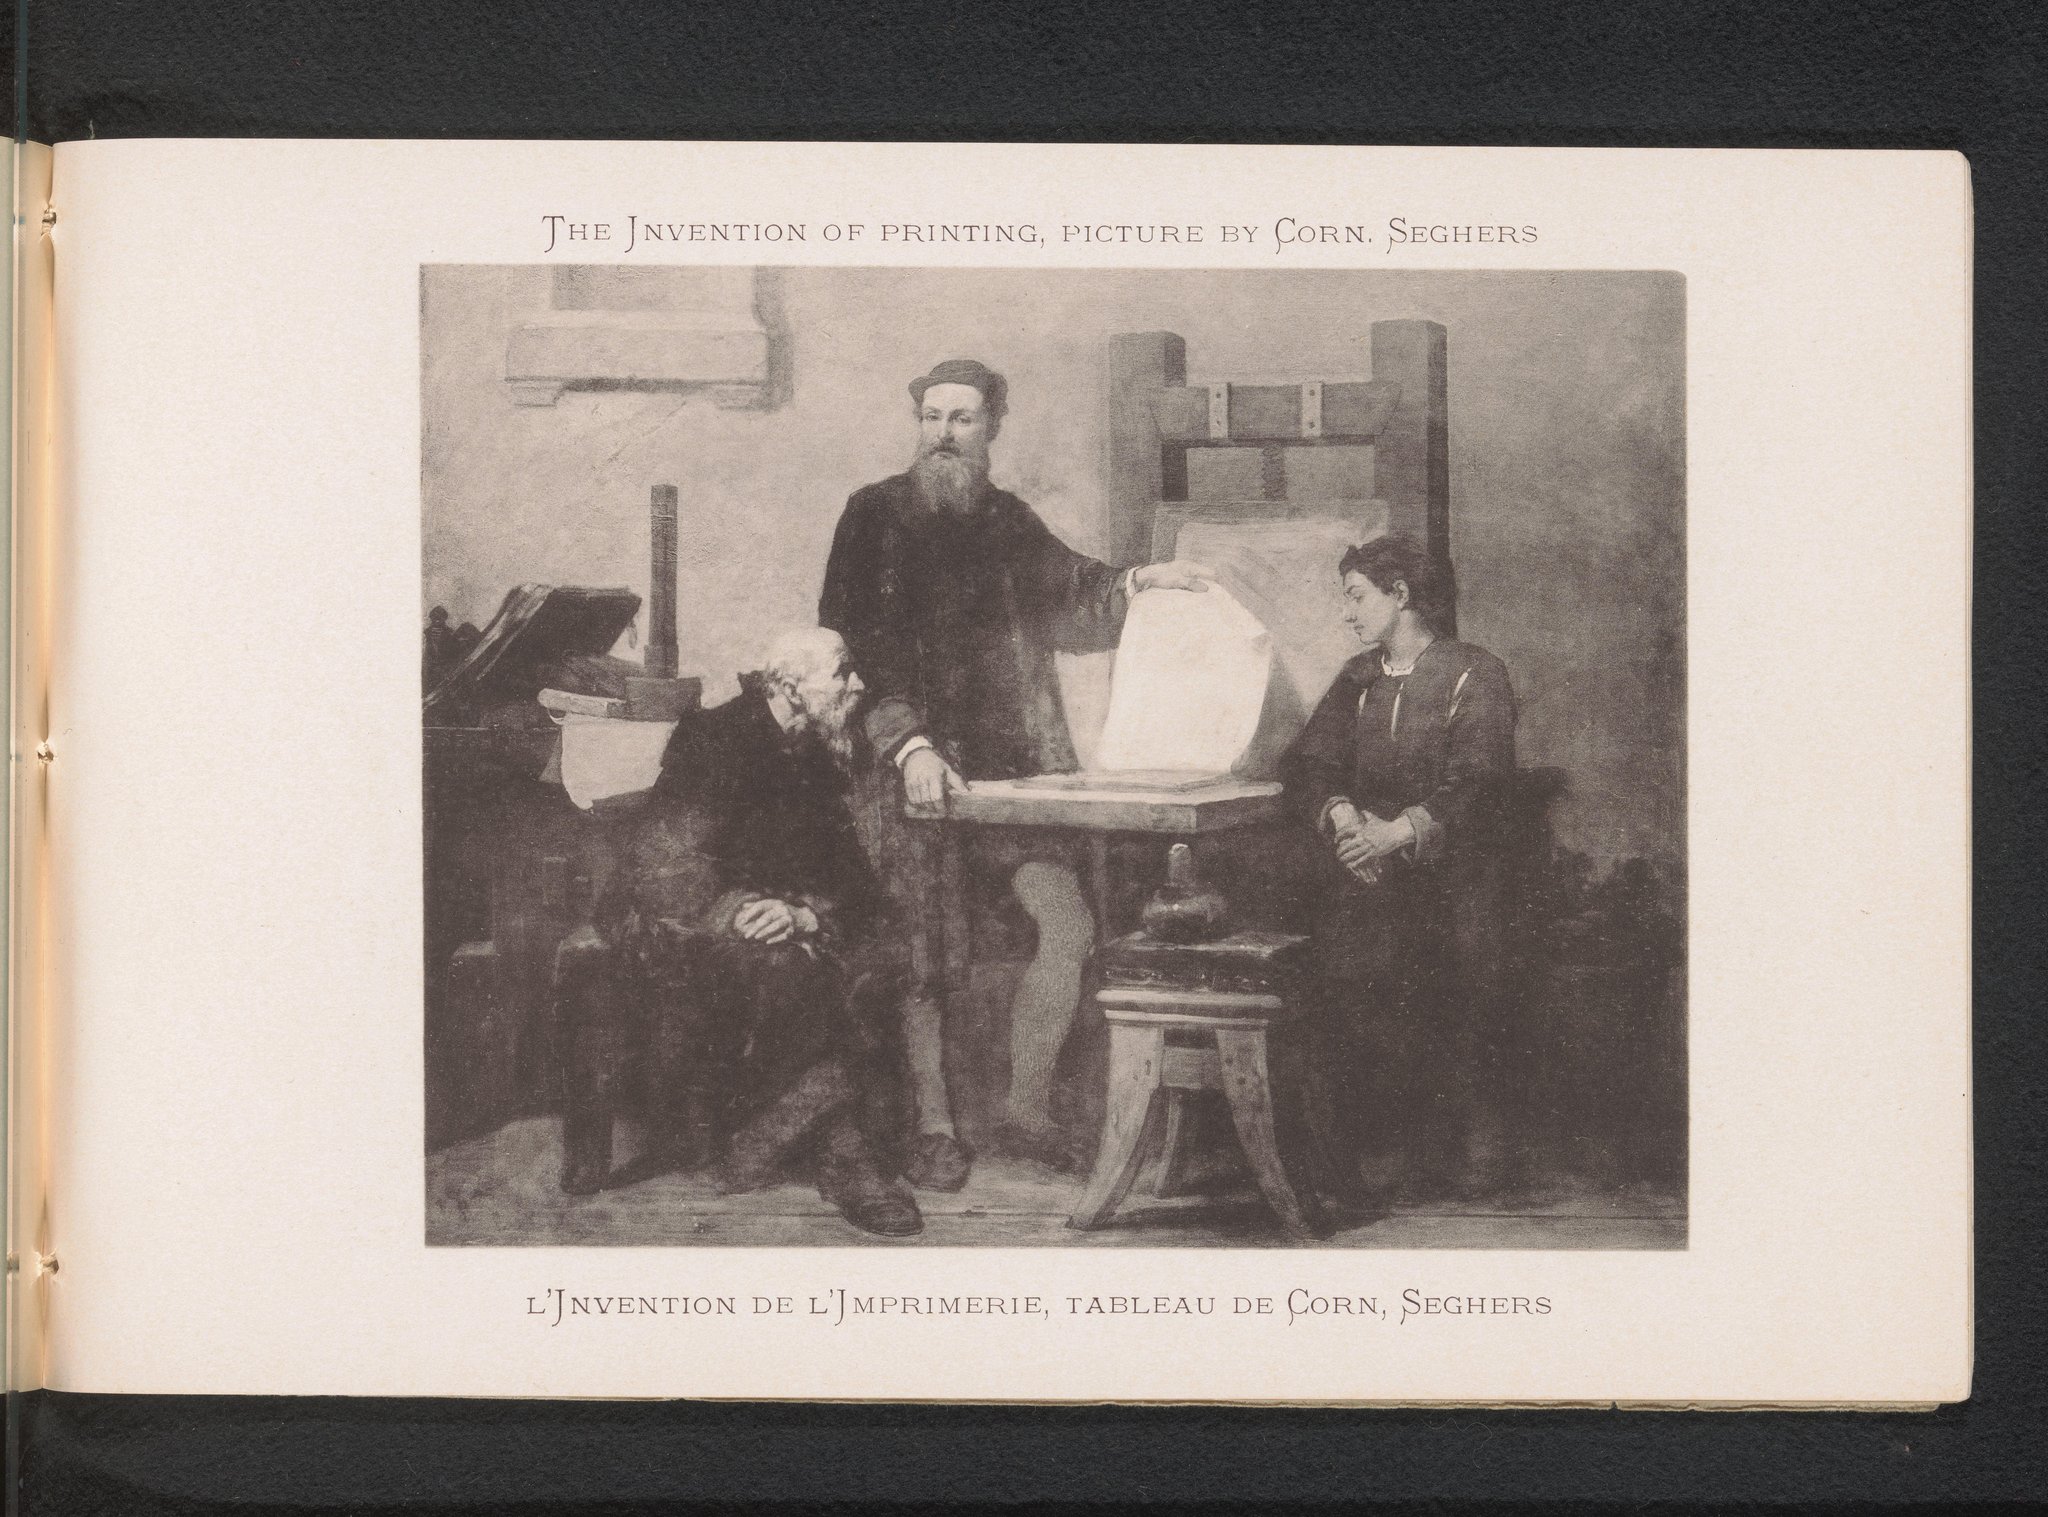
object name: reproduction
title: L'Invention de l'imprimerie, tableau de Corn. Seghers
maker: Anonymous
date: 1892-1897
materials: paper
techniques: photograph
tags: production of printed matter, book-production